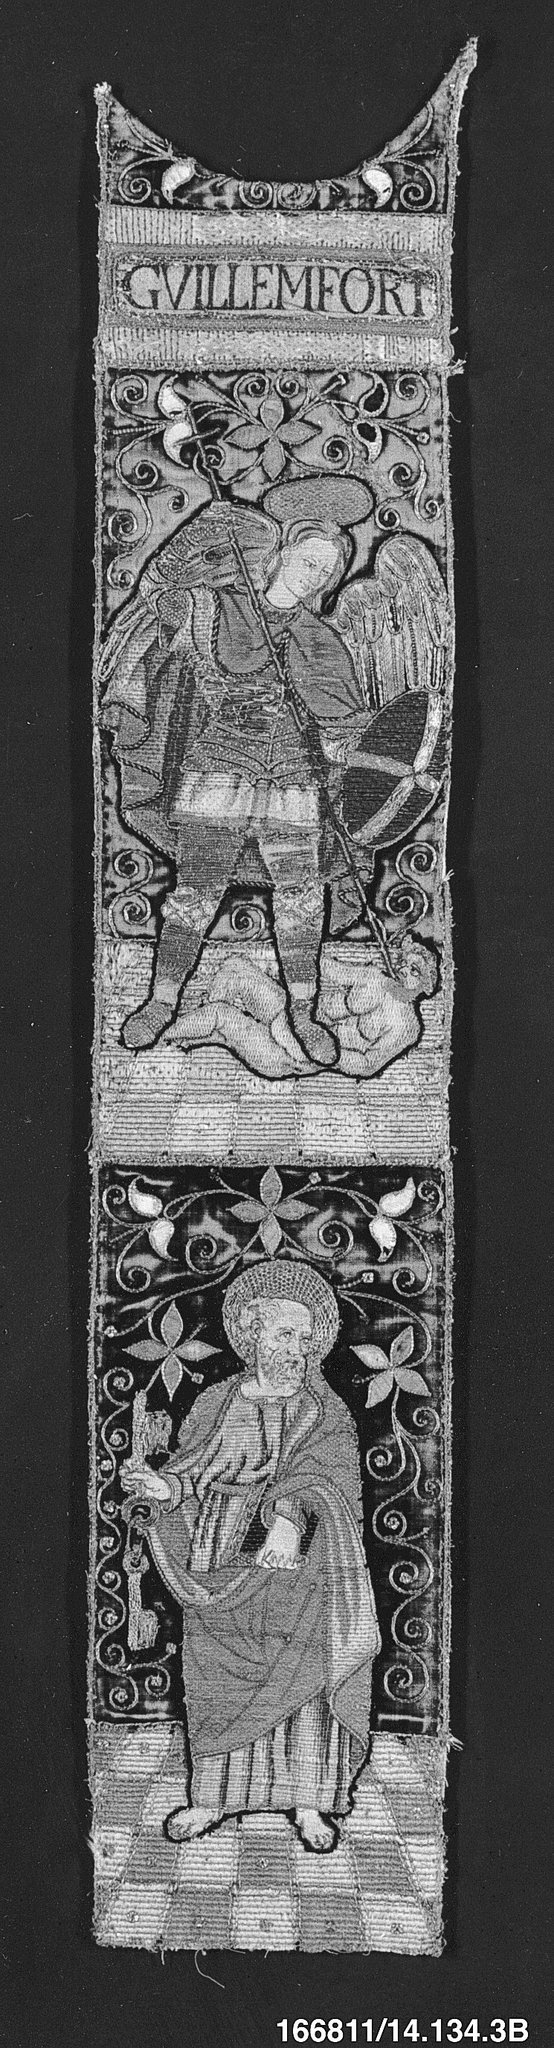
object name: orphrey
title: Orphrey (one of a pair)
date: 1601-1700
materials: metal thread, silk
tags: men,saint michael